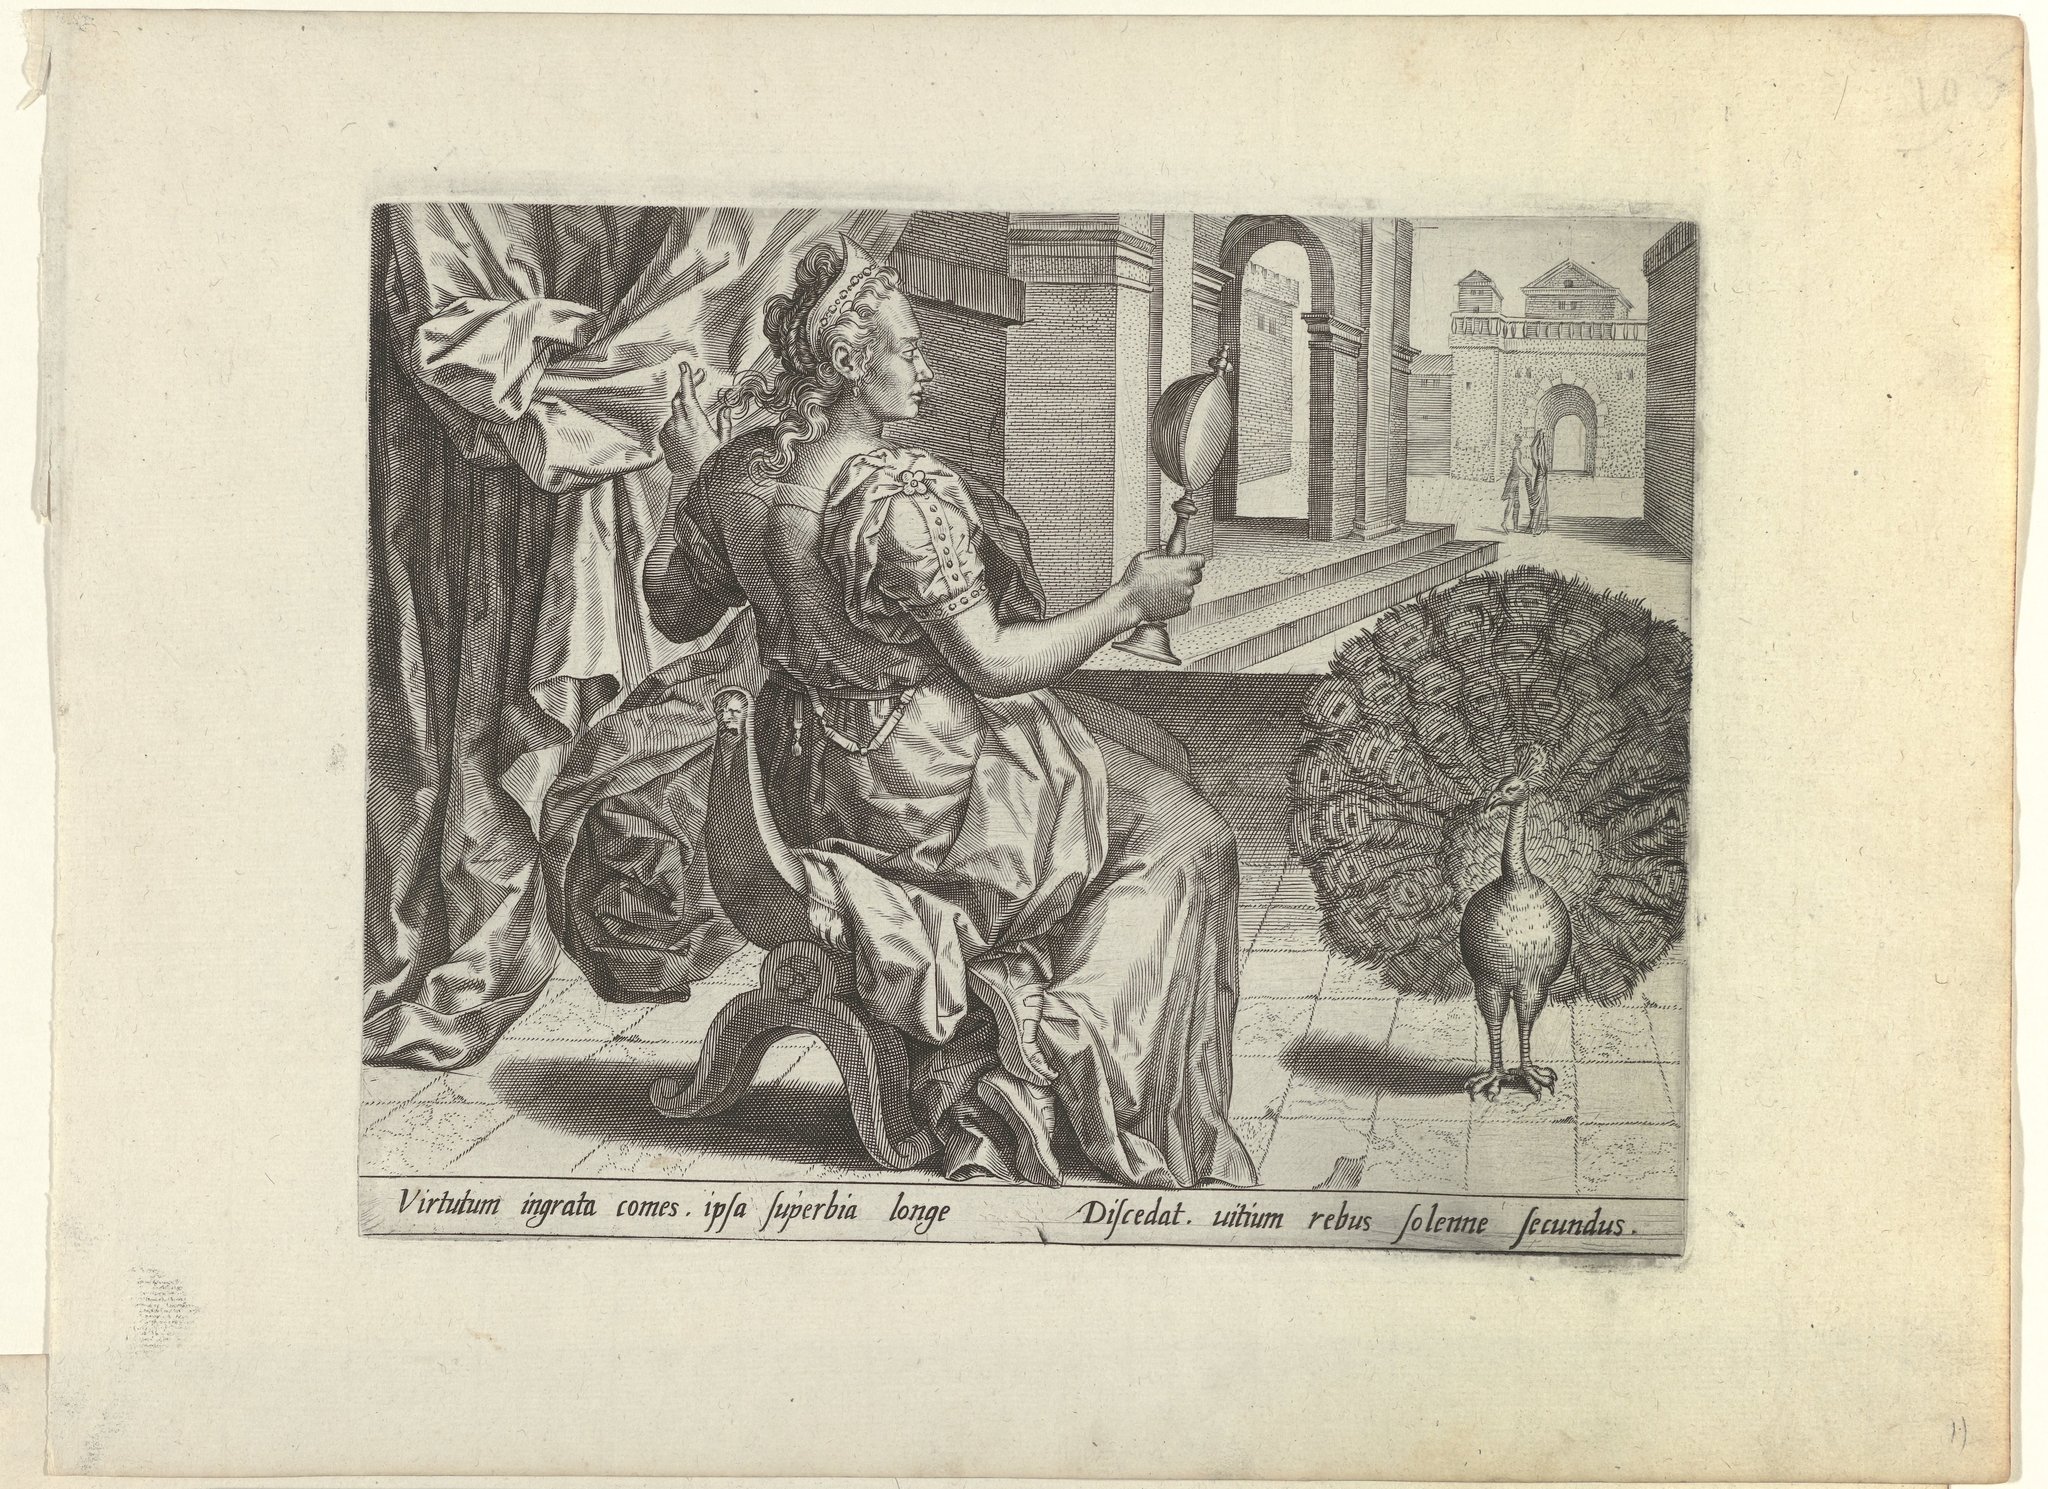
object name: print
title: Zeven doodzonden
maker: pieter jalhea furnius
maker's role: print maker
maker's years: 1540-1626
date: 1550-1625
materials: paper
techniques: engraving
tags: pride; 'superbia' (ripa) ~ personification of one of the seven deadly sins, mirror - aa - (for) women, ornamental birds: peacock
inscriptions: collector's mark: Lugt 2760, collector's mark: Lugt 2228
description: De vrouwelijke personificatie van Hoogmoed (Superbia) zit met een spiegel in haar hand, naast haar staat een pauw. De prent heeft een eenregelig Latijns onderschrift en maakt deel uit van een serie prenten over de zeven doodzonden.